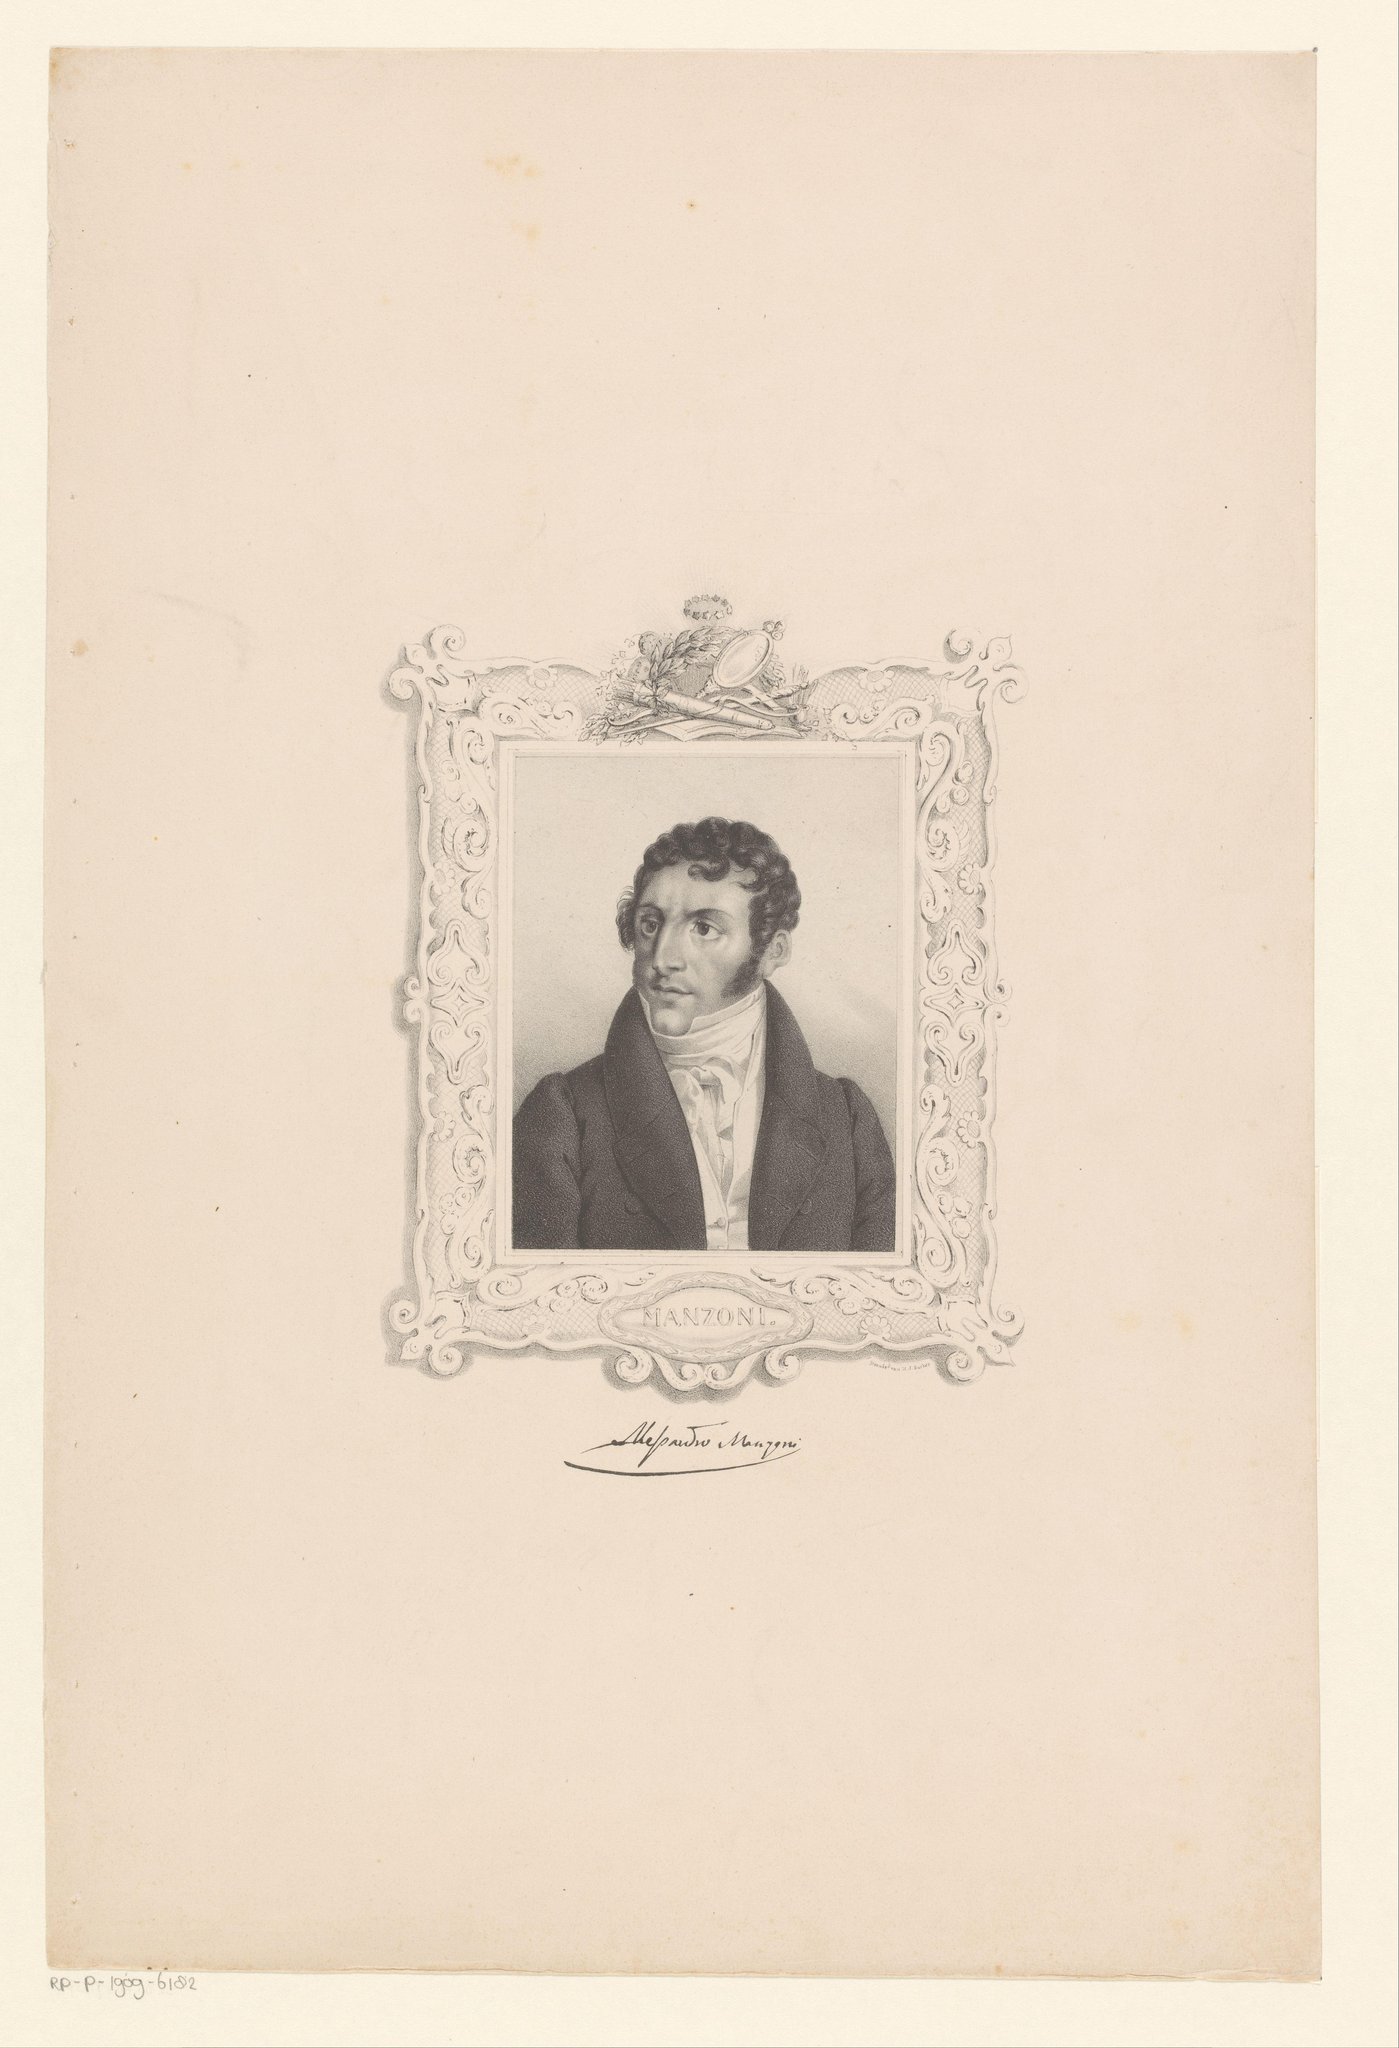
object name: print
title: Portret van de schrijver Allessandro Manzoni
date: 1822-1845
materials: paper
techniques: lithograph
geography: dordrecht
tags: historical persons, frame of painting, etc.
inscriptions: collector's mark: Lugt 2228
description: Het portret is omlijst met een sierlijst. Bovenin de lijst een spiegel, lauwerkranst, boek, een masker, pijlen, een zwaard en een krans van sterren. Onderin de lijst staat zijn naam. Onder het portret de signatuur van de geportretteerde.